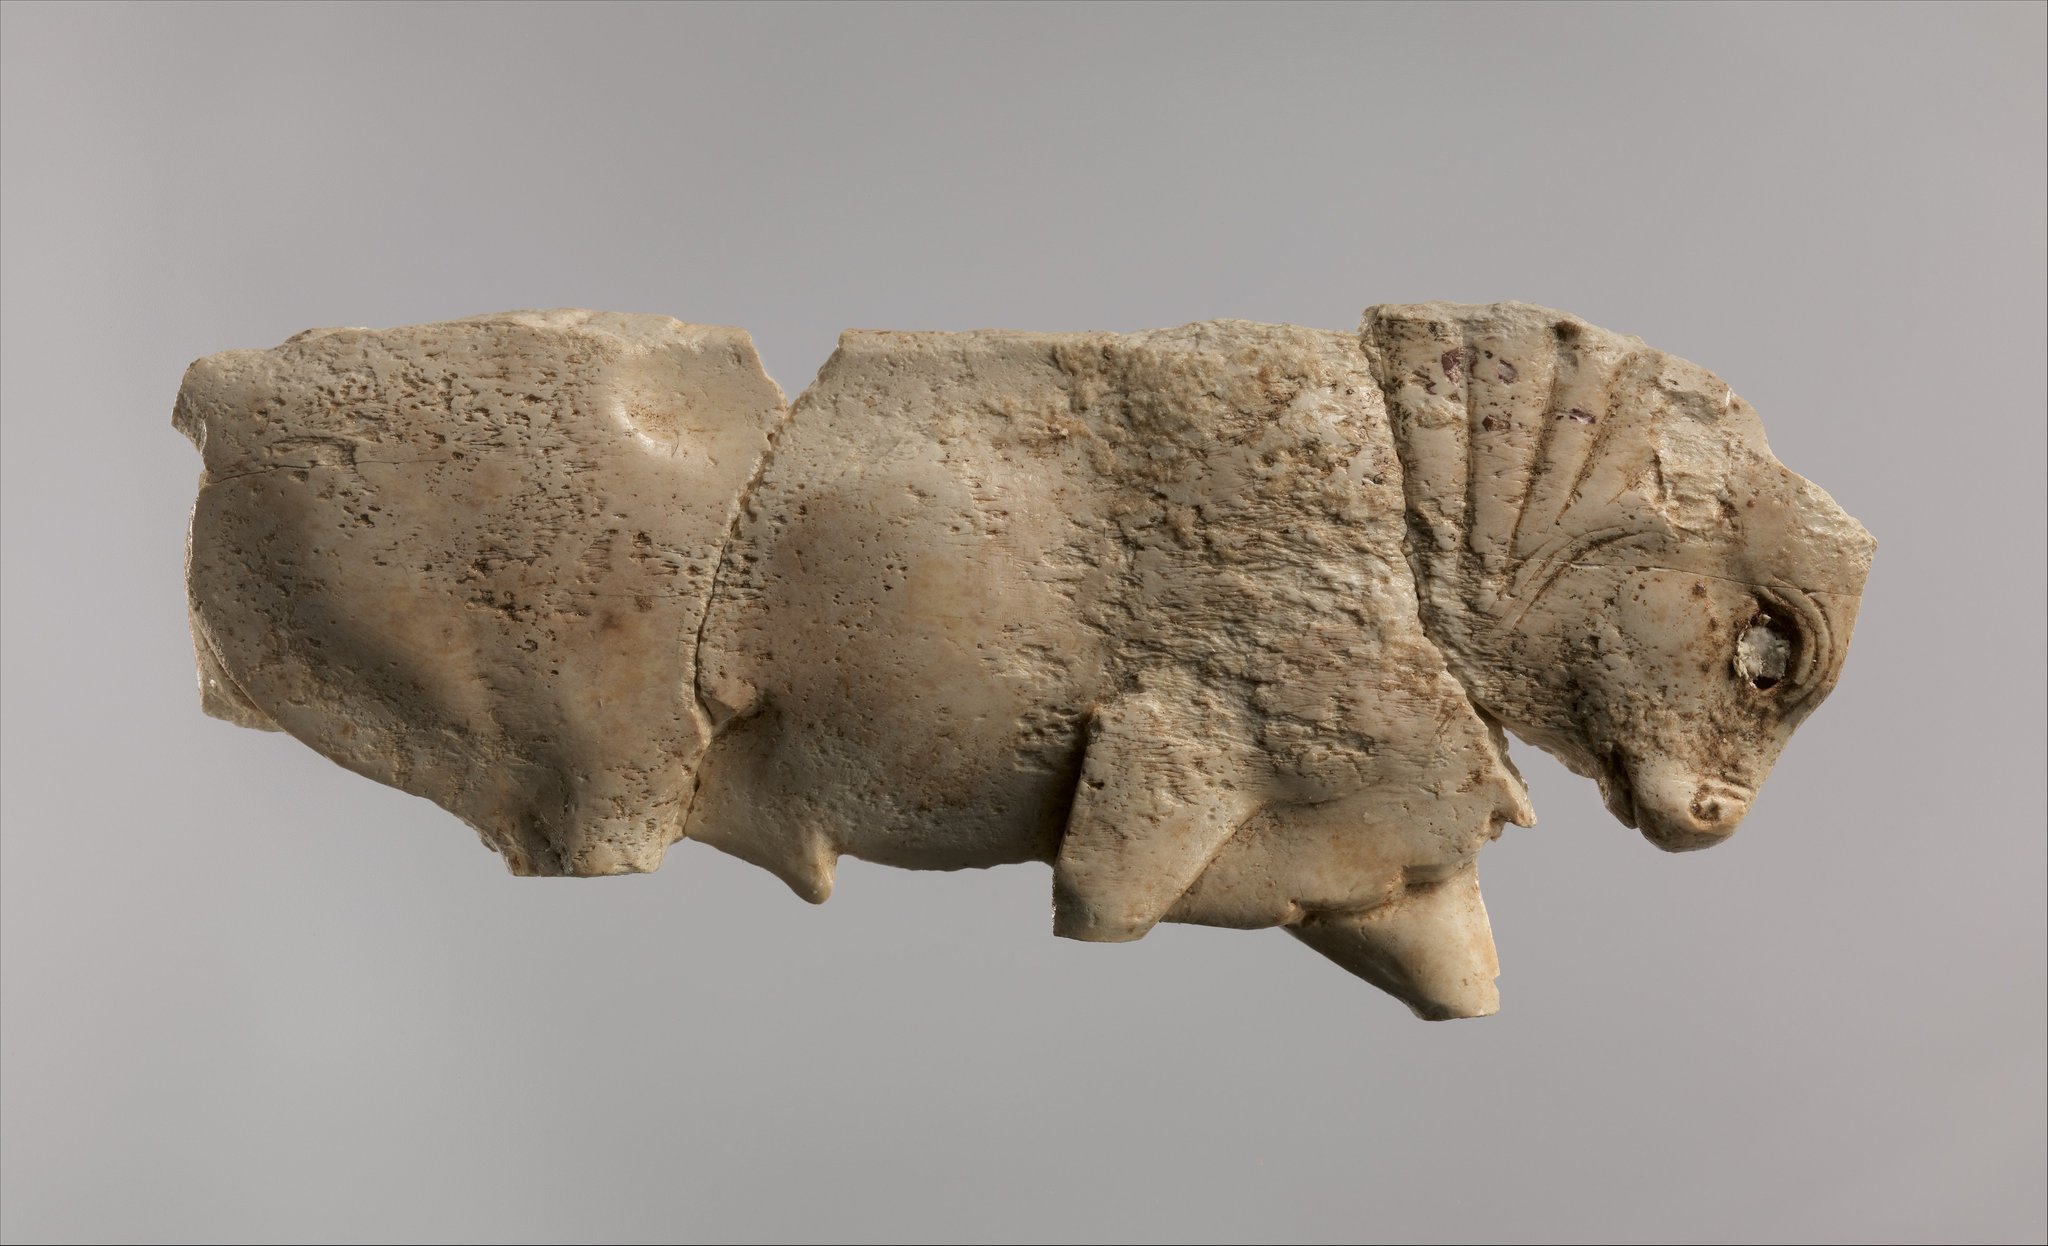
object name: relief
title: Openwork furniture plaque with a striding bull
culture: assyrian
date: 900-701 BCE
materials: ivory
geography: syria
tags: bulls